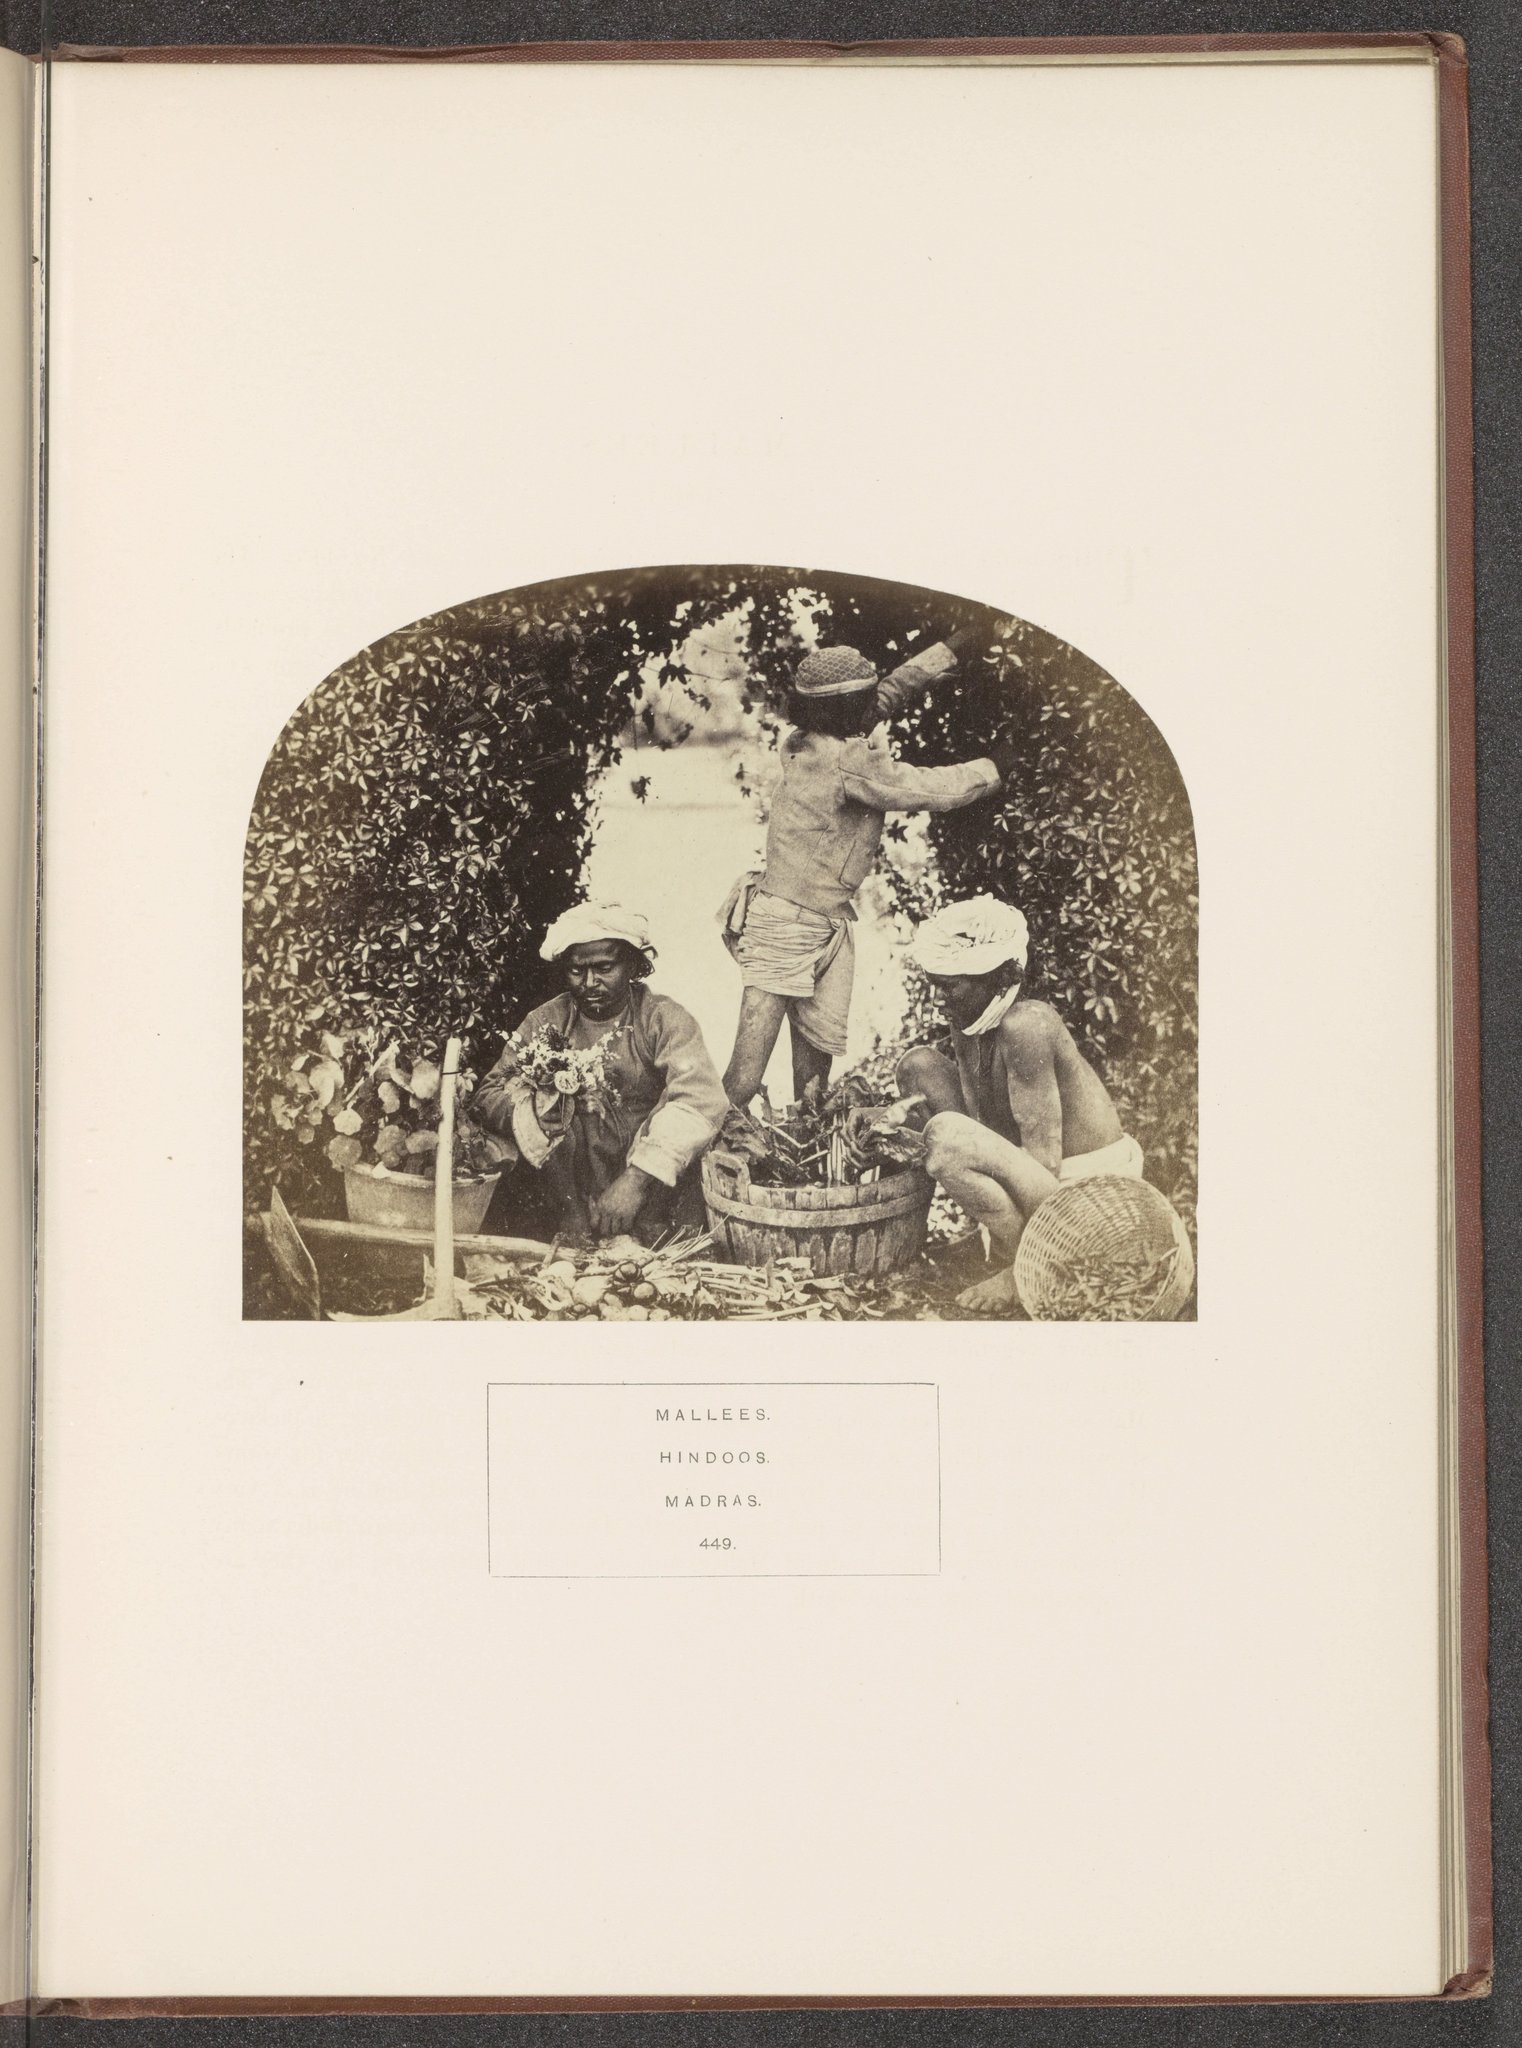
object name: page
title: Three gardeners at work in Chennai, Tamil Nadu, India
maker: Anonymous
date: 1865-1875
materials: photographic support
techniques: albumen print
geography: chennai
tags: gardening, picking fruit, human races; peoples; nationalities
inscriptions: number: ‘449.’, inscription: ‘MALLEES./ HINDOOS./ MADRAS.’